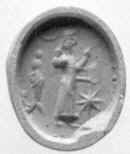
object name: stamp seal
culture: achaemenid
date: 600-301 BCE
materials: stone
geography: iran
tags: fish